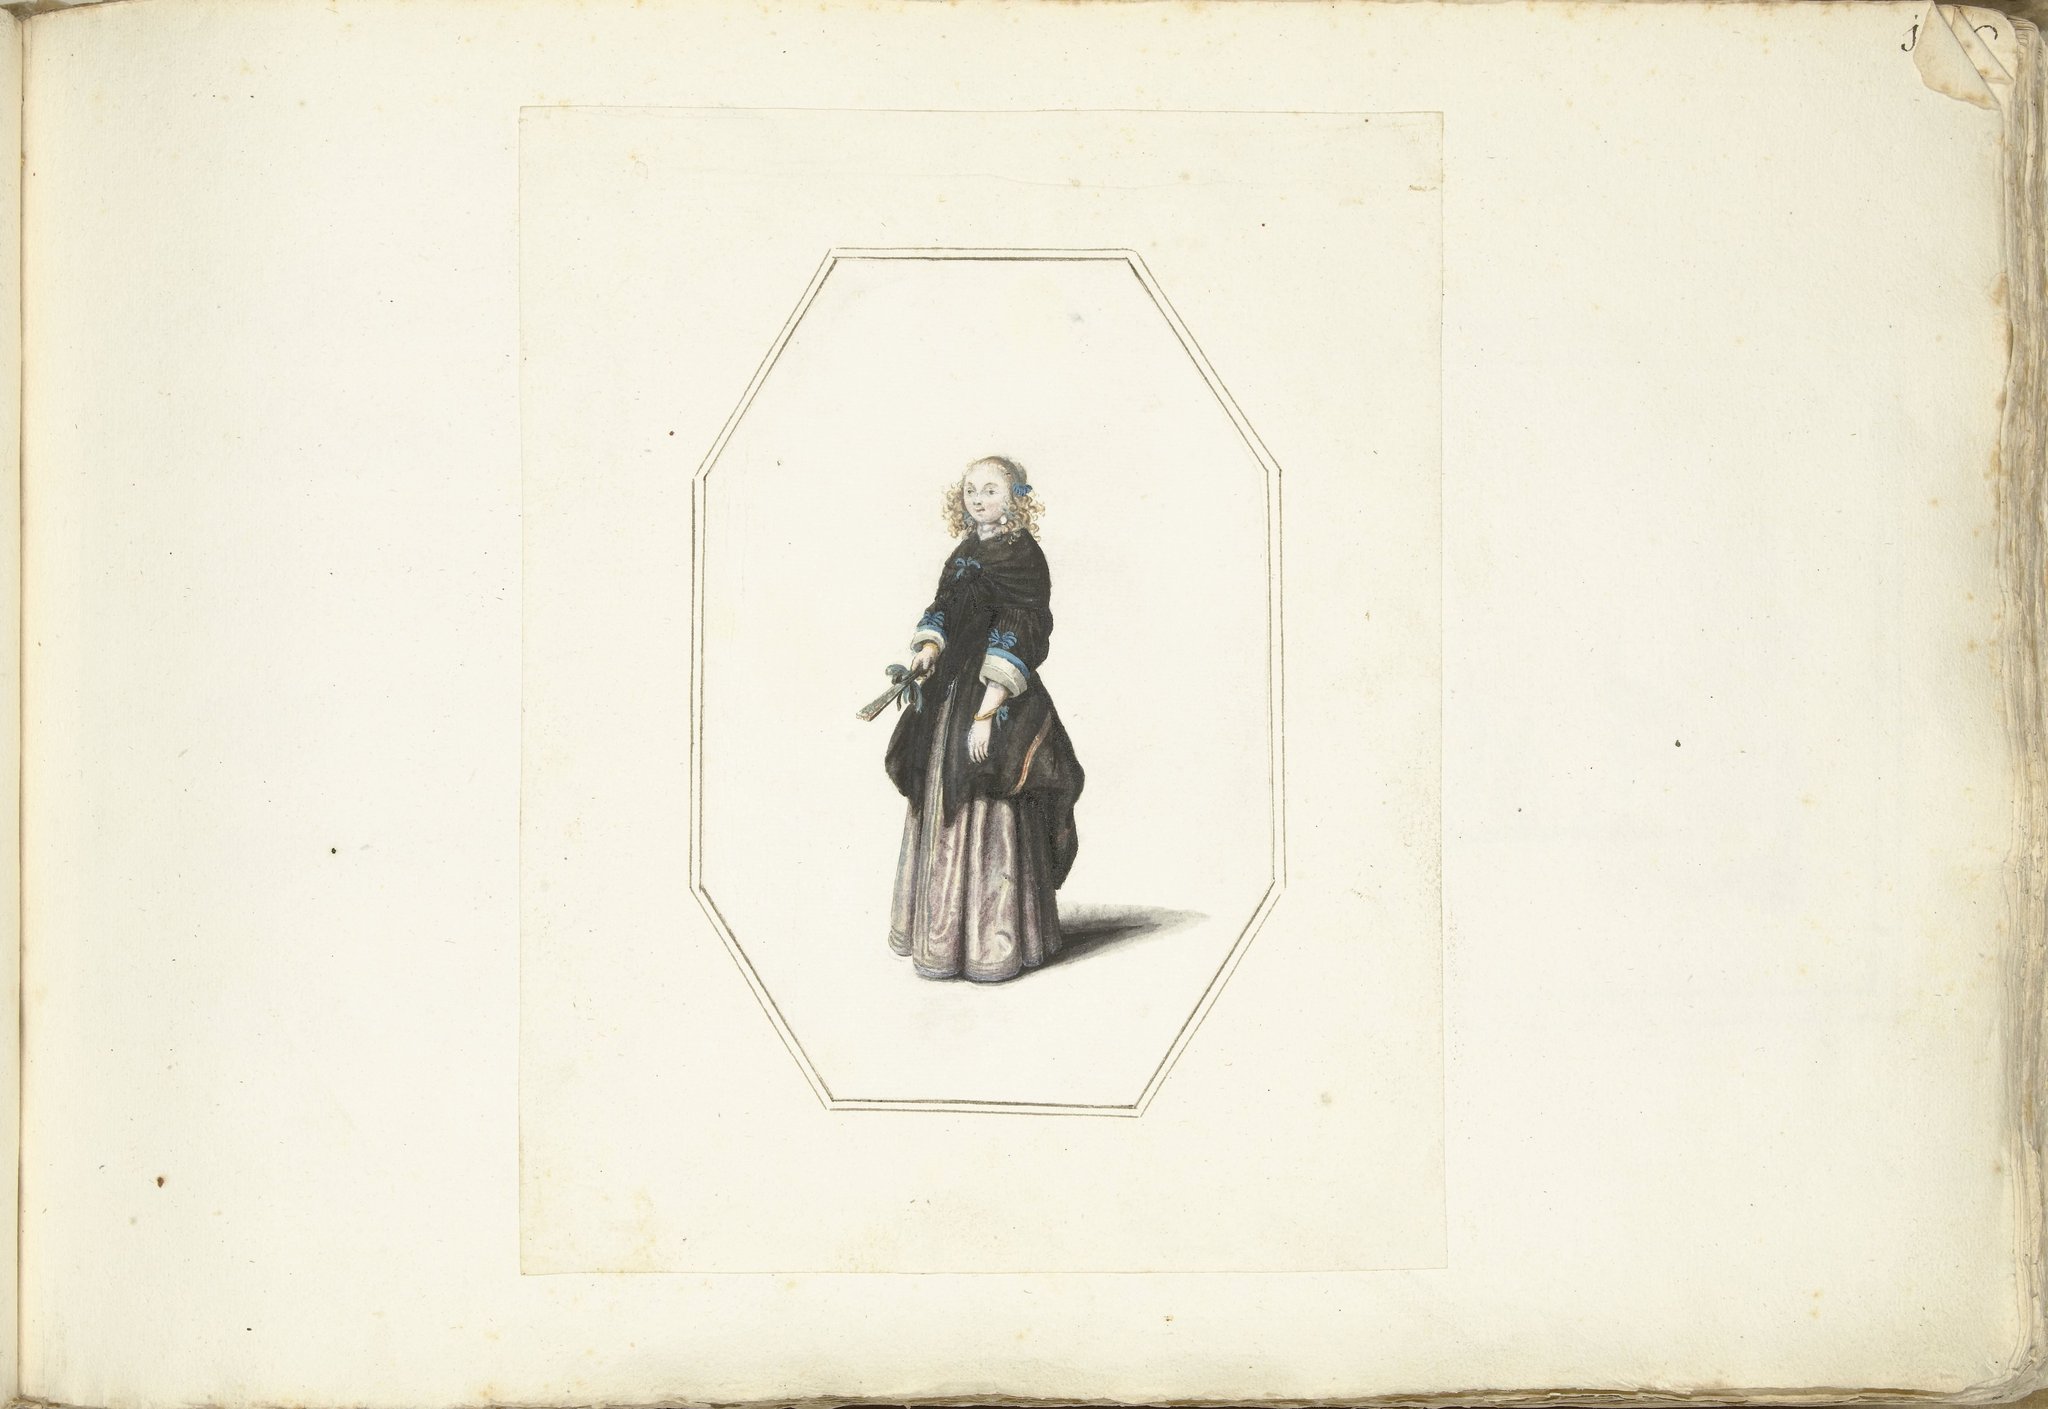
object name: drawing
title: Staande vrouw, in achthoekige omlijsting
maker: gesina ter borch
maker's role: draughtsman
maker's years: 1633-1690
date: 1654-1655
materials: chalk, paper, watercolor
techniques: brush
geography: zwolle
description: De tekening hoort waarschijnlijk bij de serie kostuumstudies die Gesina midden jaren 1650 maakte. De achthoekige tekening is opgeplakt op een blad papier dat weer in het Plakboek geplakt is.